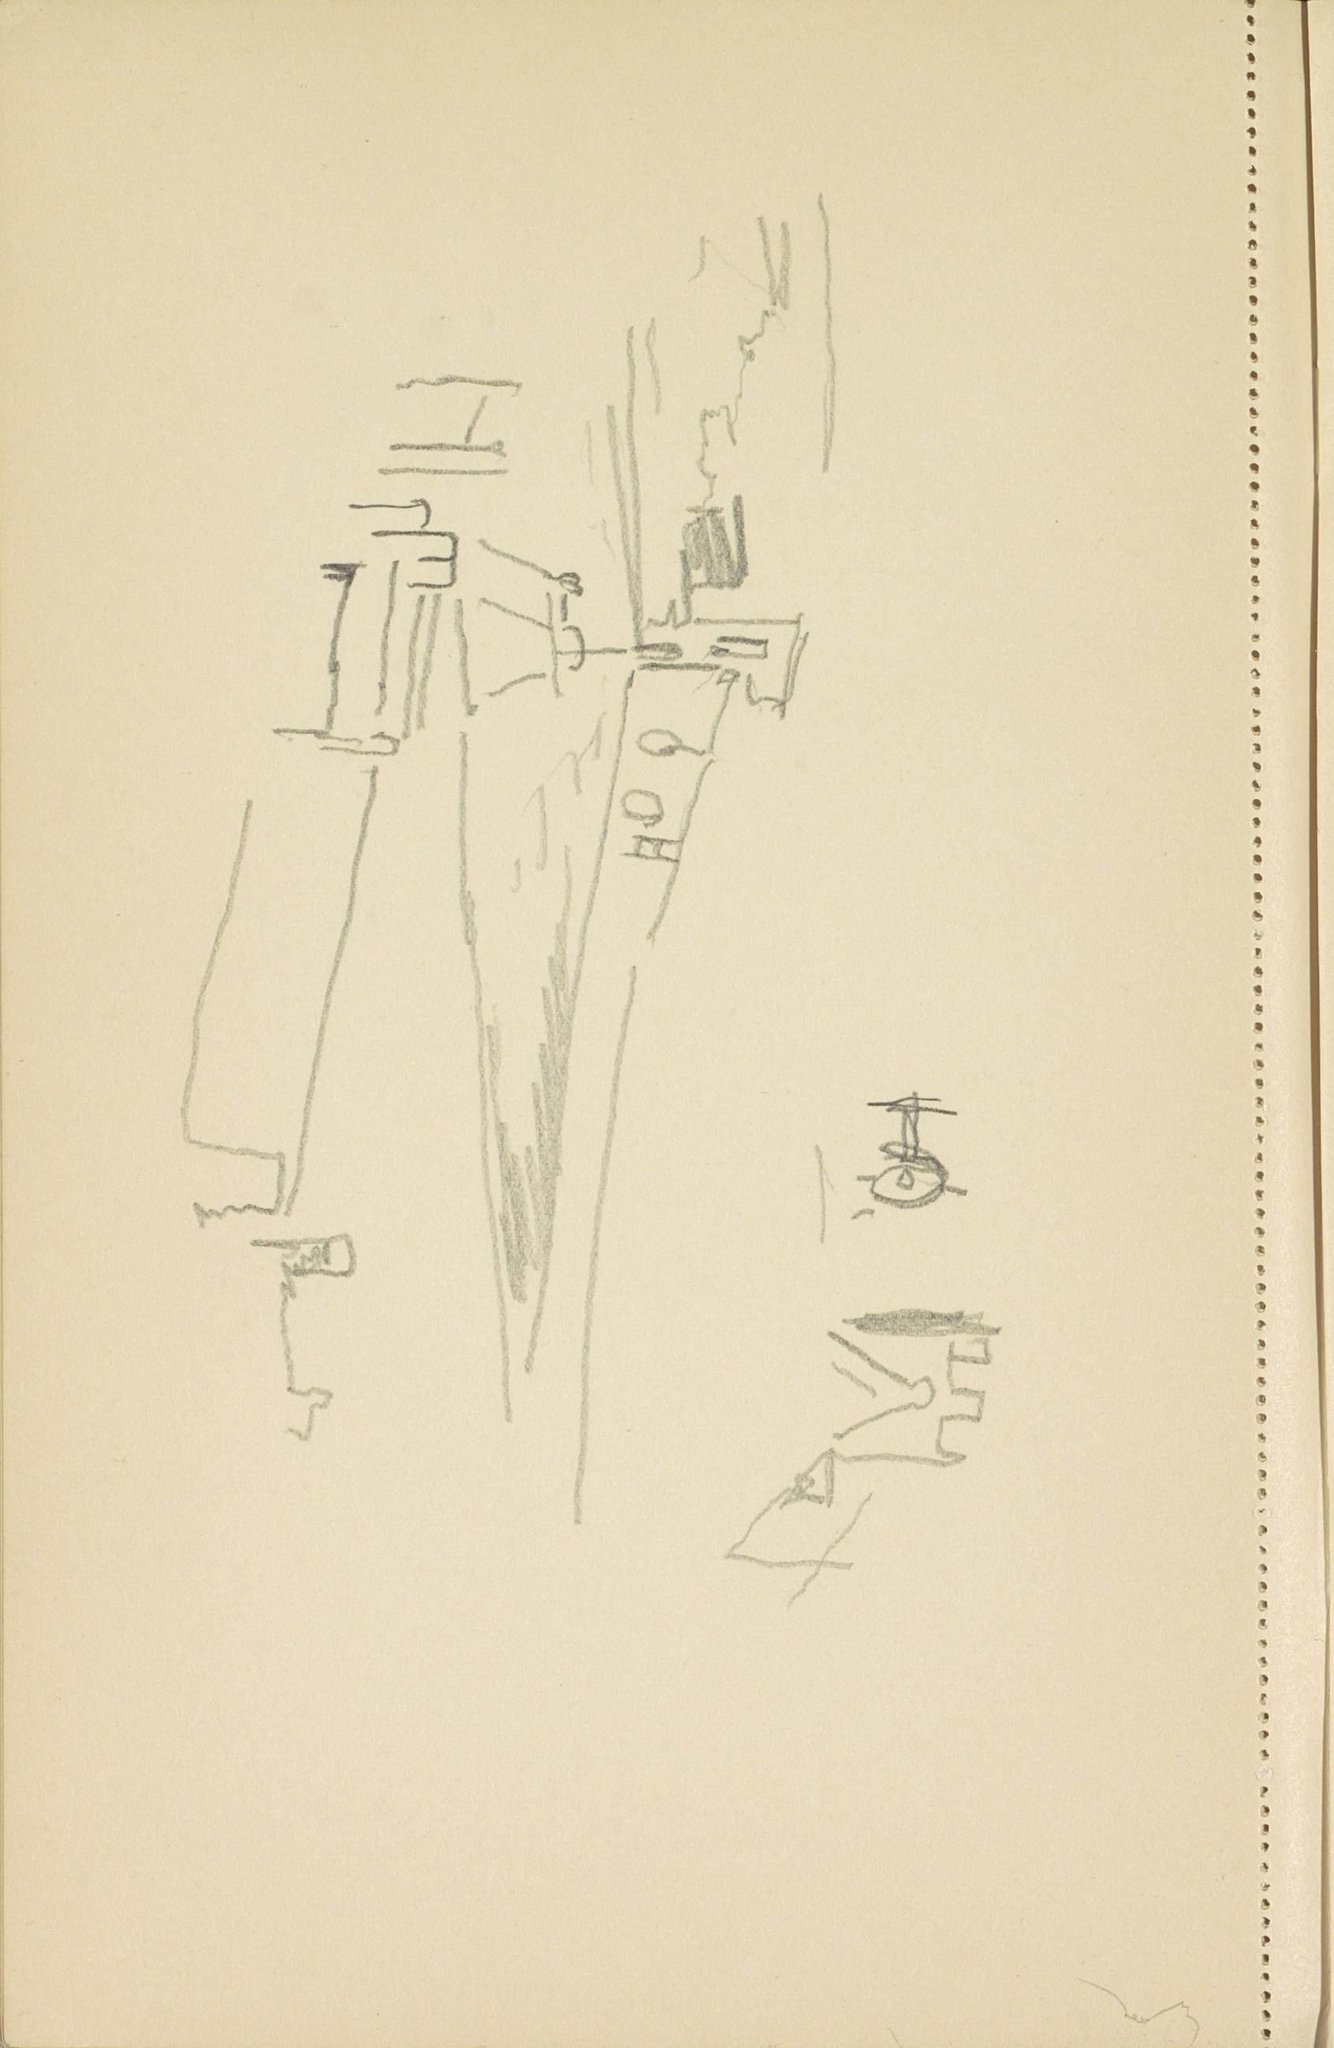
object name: sketchbook leaf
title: Hek bij een kade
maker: cornelis vreedenburgh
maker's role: draughtsman, print maker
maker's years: 1880-1946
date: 1890-1946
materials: paper, pencil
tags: fence, wall, paling, quay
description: Blad 56 verso uit een schetsboek met 73 bladen.